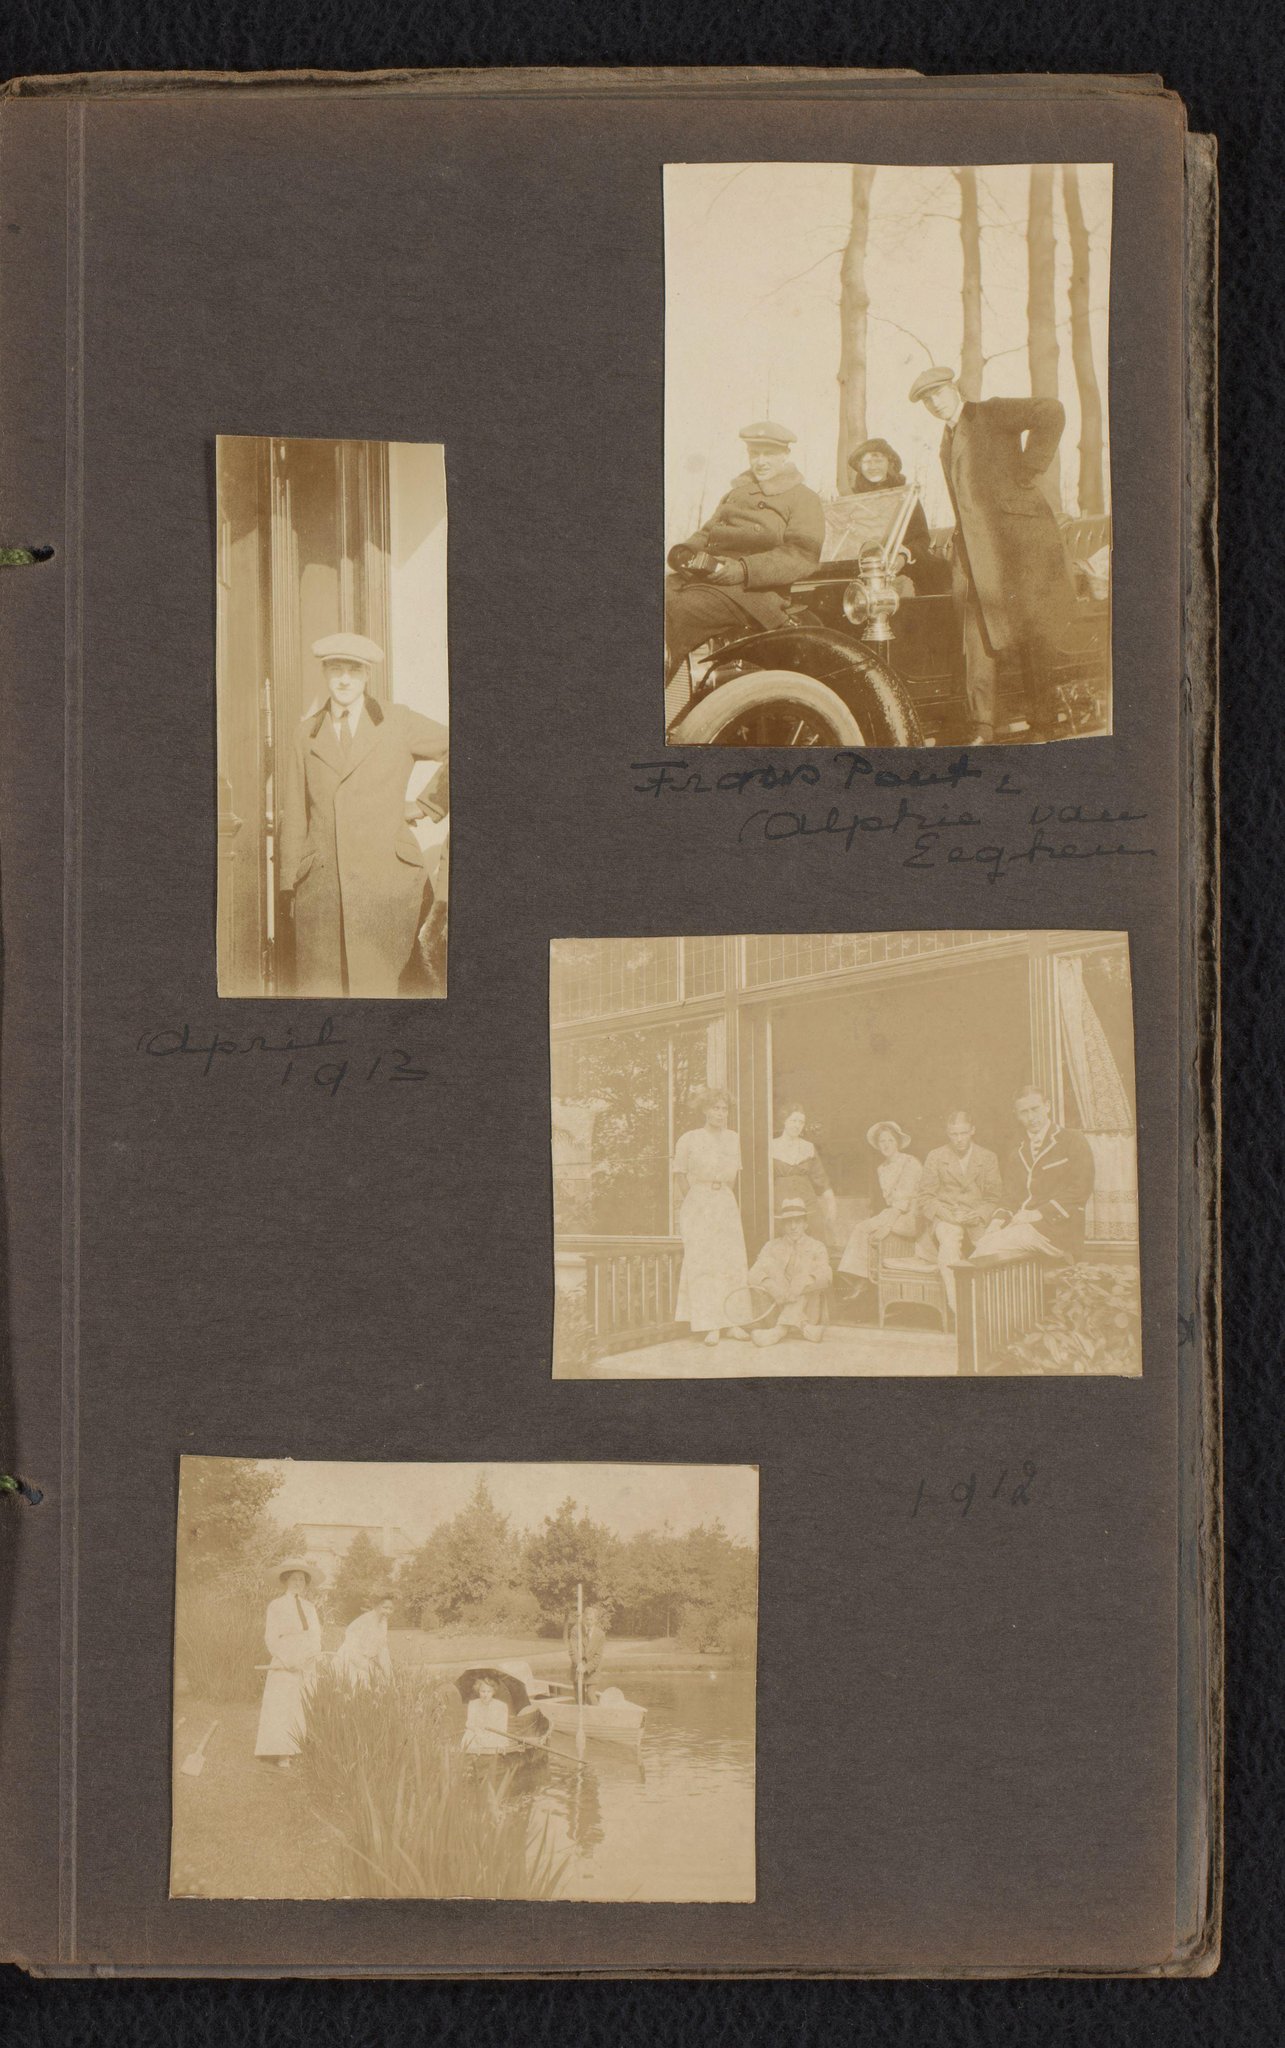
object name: album leaf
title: Vrienden van Loentje Onnen, waaronder Frans Paut en Alphie van Eeghen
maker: carolina frederika onnen (lien/loen)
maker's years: 1896-1983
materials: paper, cardboard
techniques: gelatin silver print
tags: anonymous historical persons portrayed in a group, in a group-portrait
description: Deze foto's zijn onderdeel van een album.